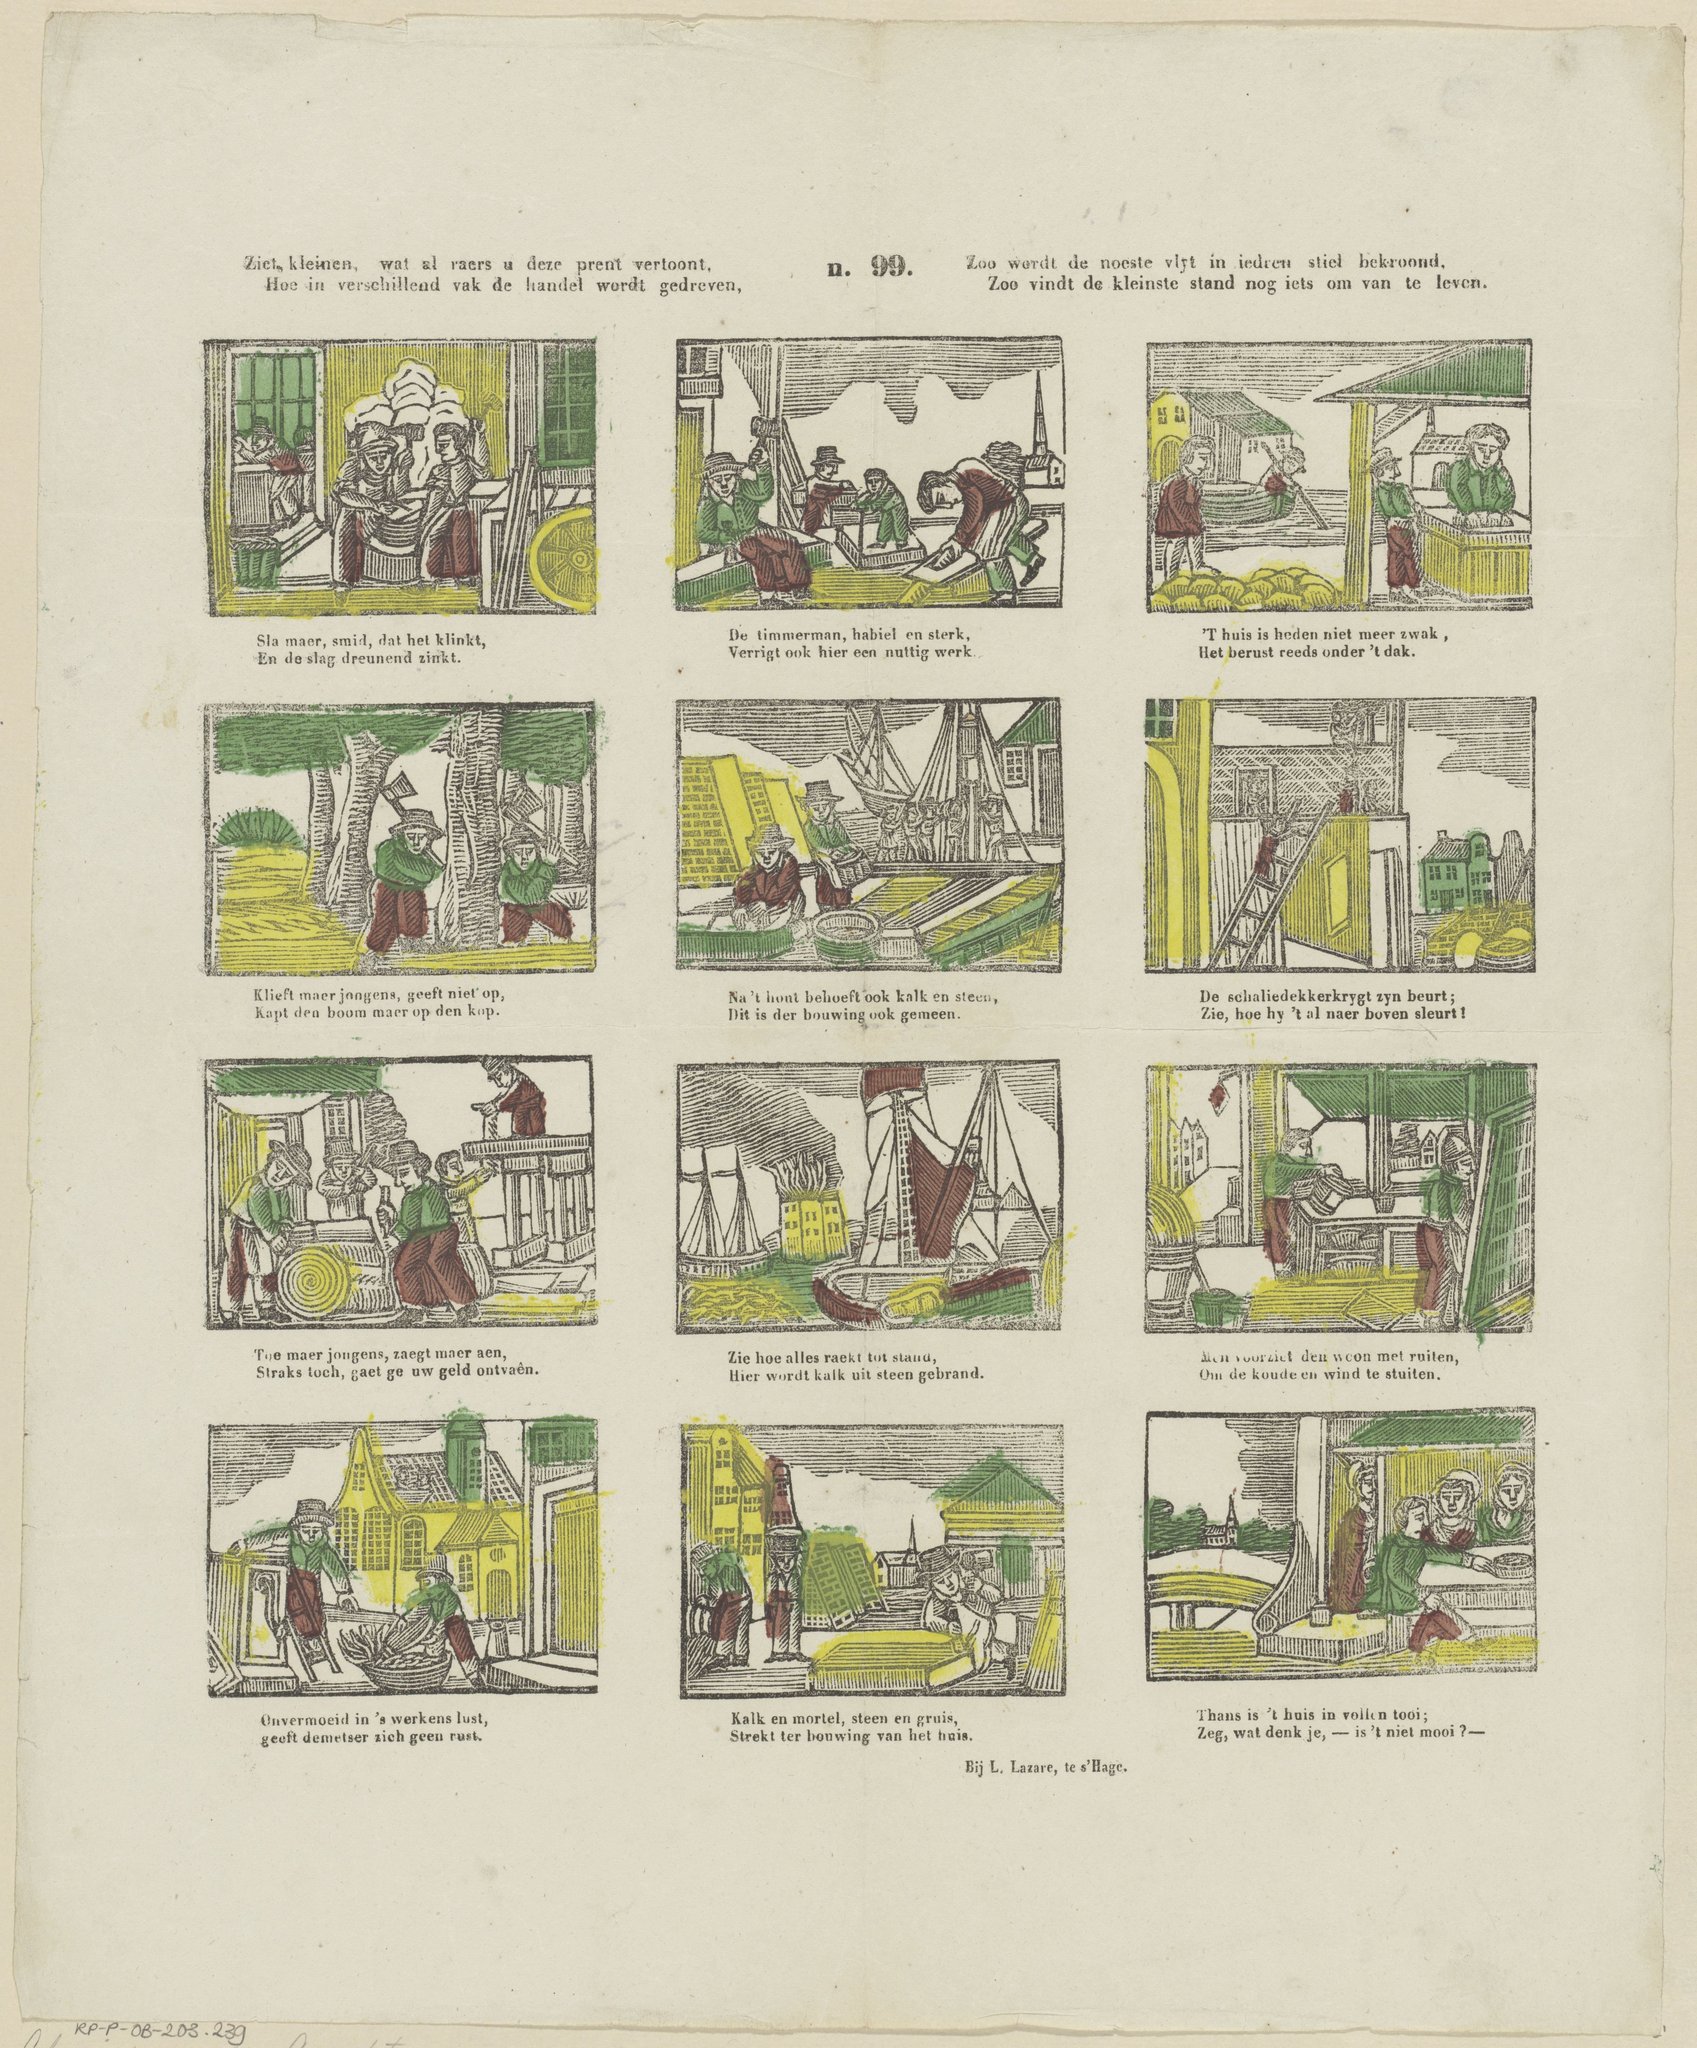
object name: print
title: Ziet, kleinen, wat al raers u deze prent vertoont, / Hoe in verschillend vak de handel wordt gedreven, / Zoo wordt de noeste vlyt in iedren stiel bekroond, / Zoo vindt de kleinste stand nog iets om van te leven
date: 1833-1900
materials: paper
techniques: colour, letterpress printing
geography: netherlands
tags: carpenter, craft-production, skilled handiwork, smith, blacksmith, crafts and industries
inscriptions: collector's mark: Lugt 2760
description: Blad met 12 voorstellingen van ambachtslieden en beroepen, zoals smid en timmerman. Onder elke afbeelding een tweeregelig vers. Genummerd midden boven: n. 99.